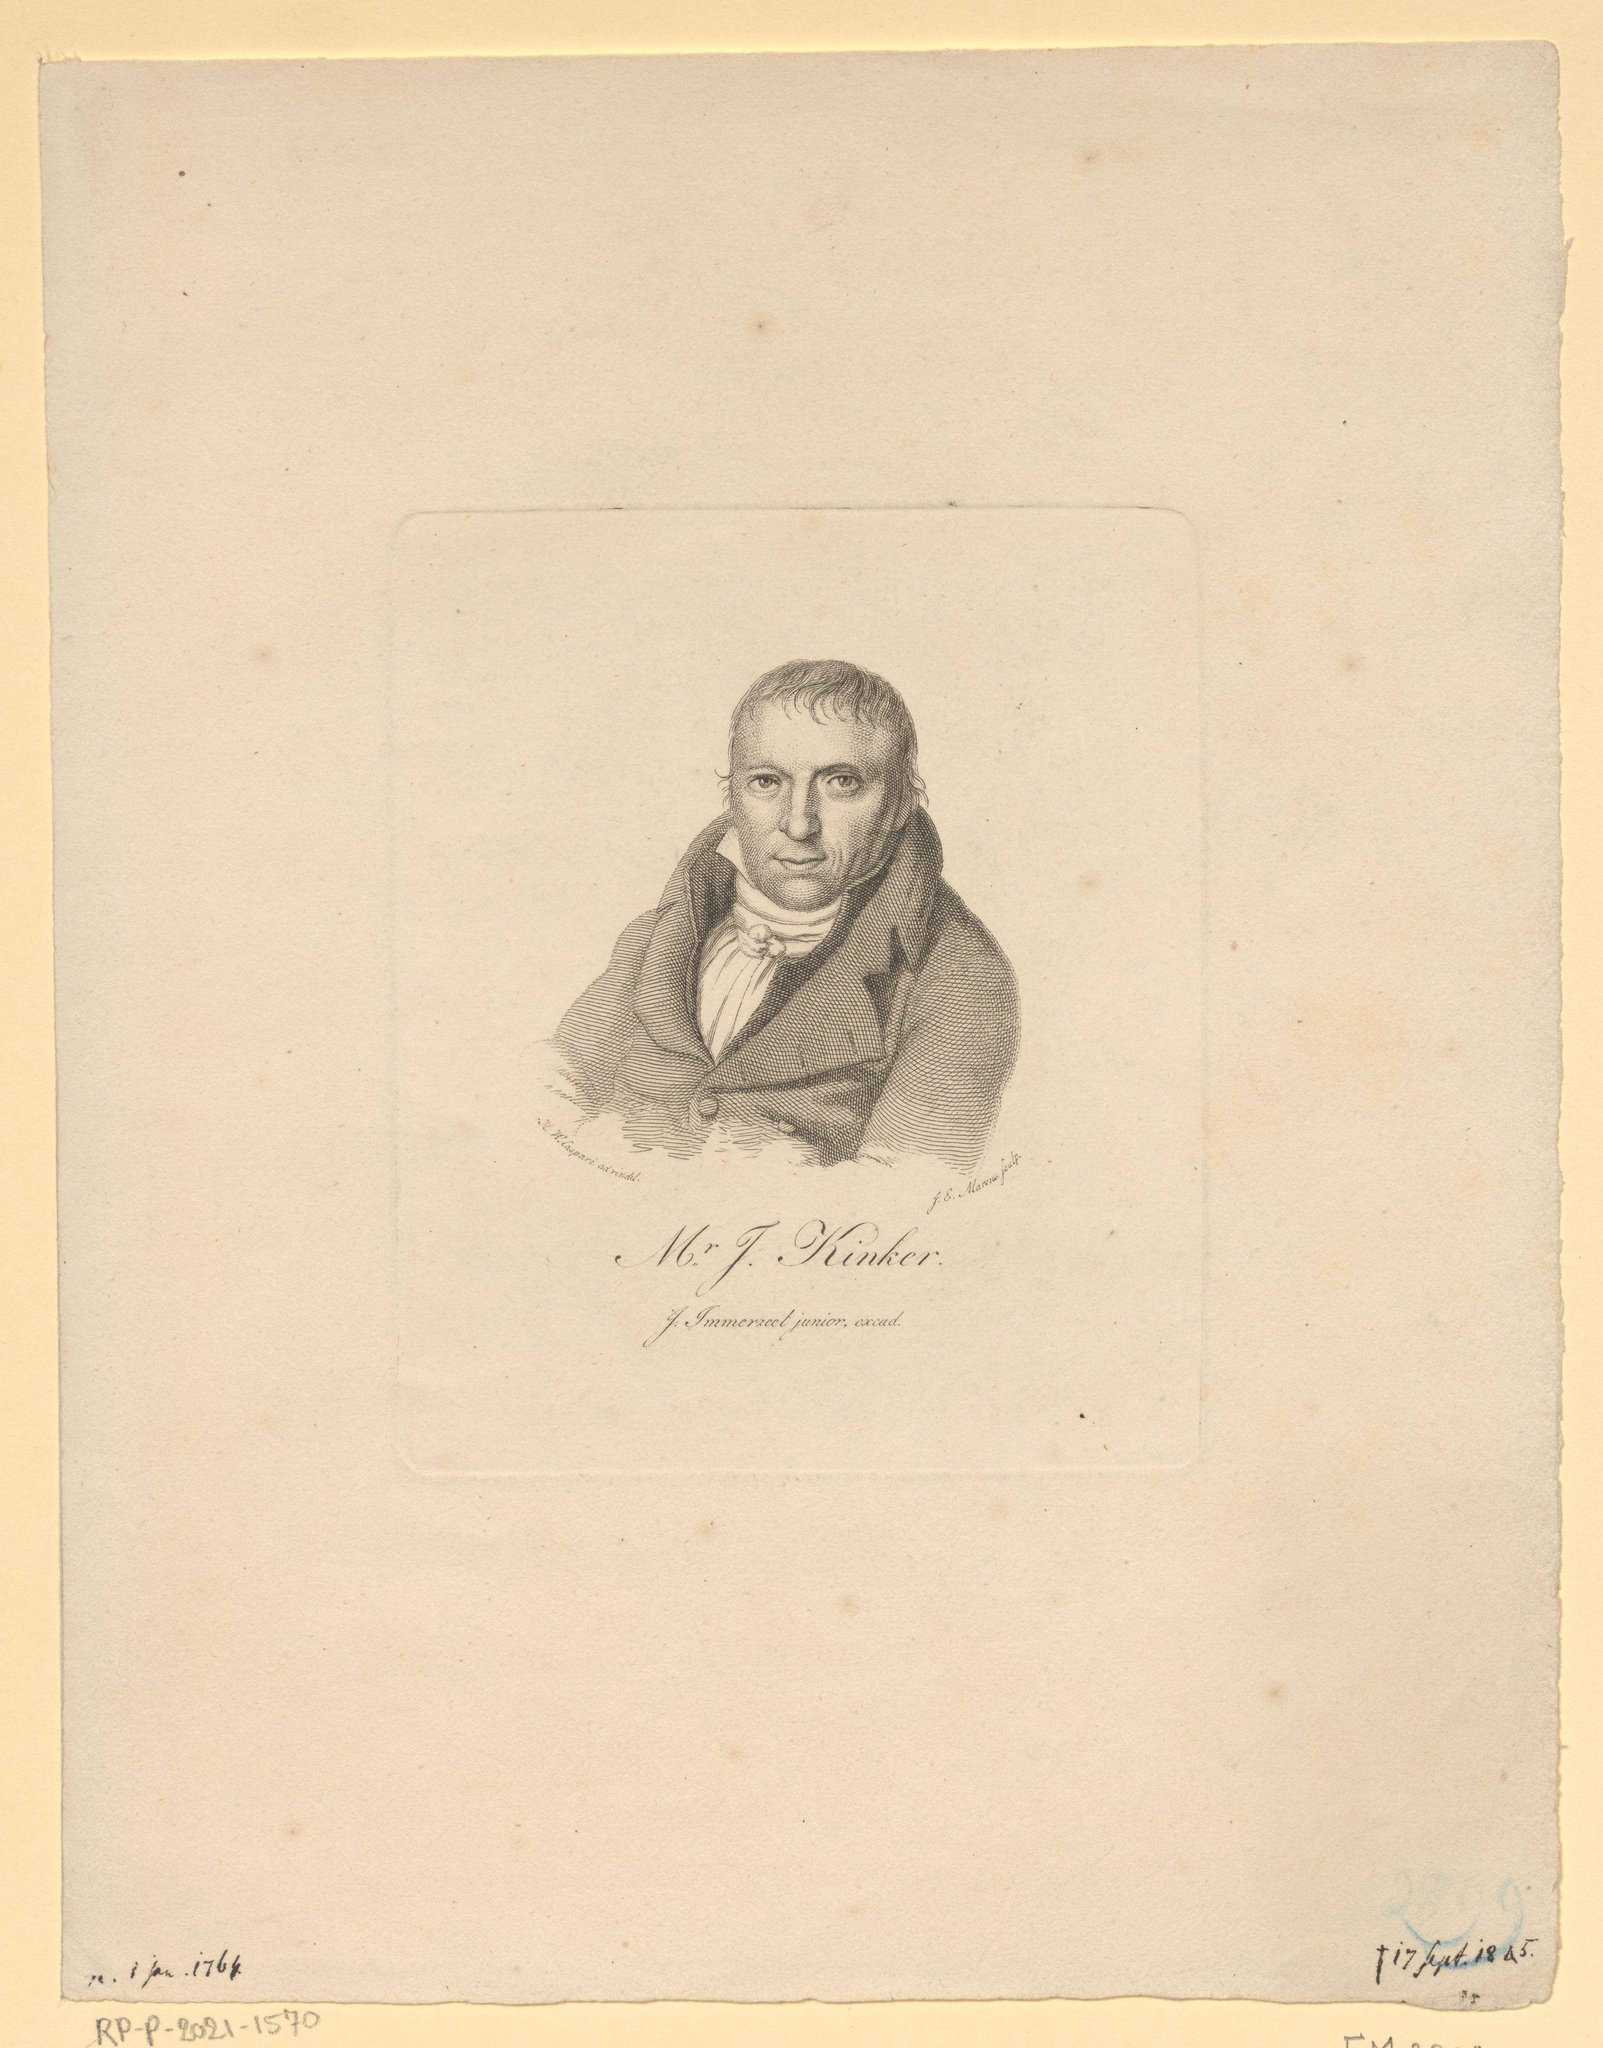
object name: print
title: Portret van Johannes Kinker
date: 1811-1841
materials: paper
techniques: engraving, etching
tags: amsterdam, johannes kinker, historical persons